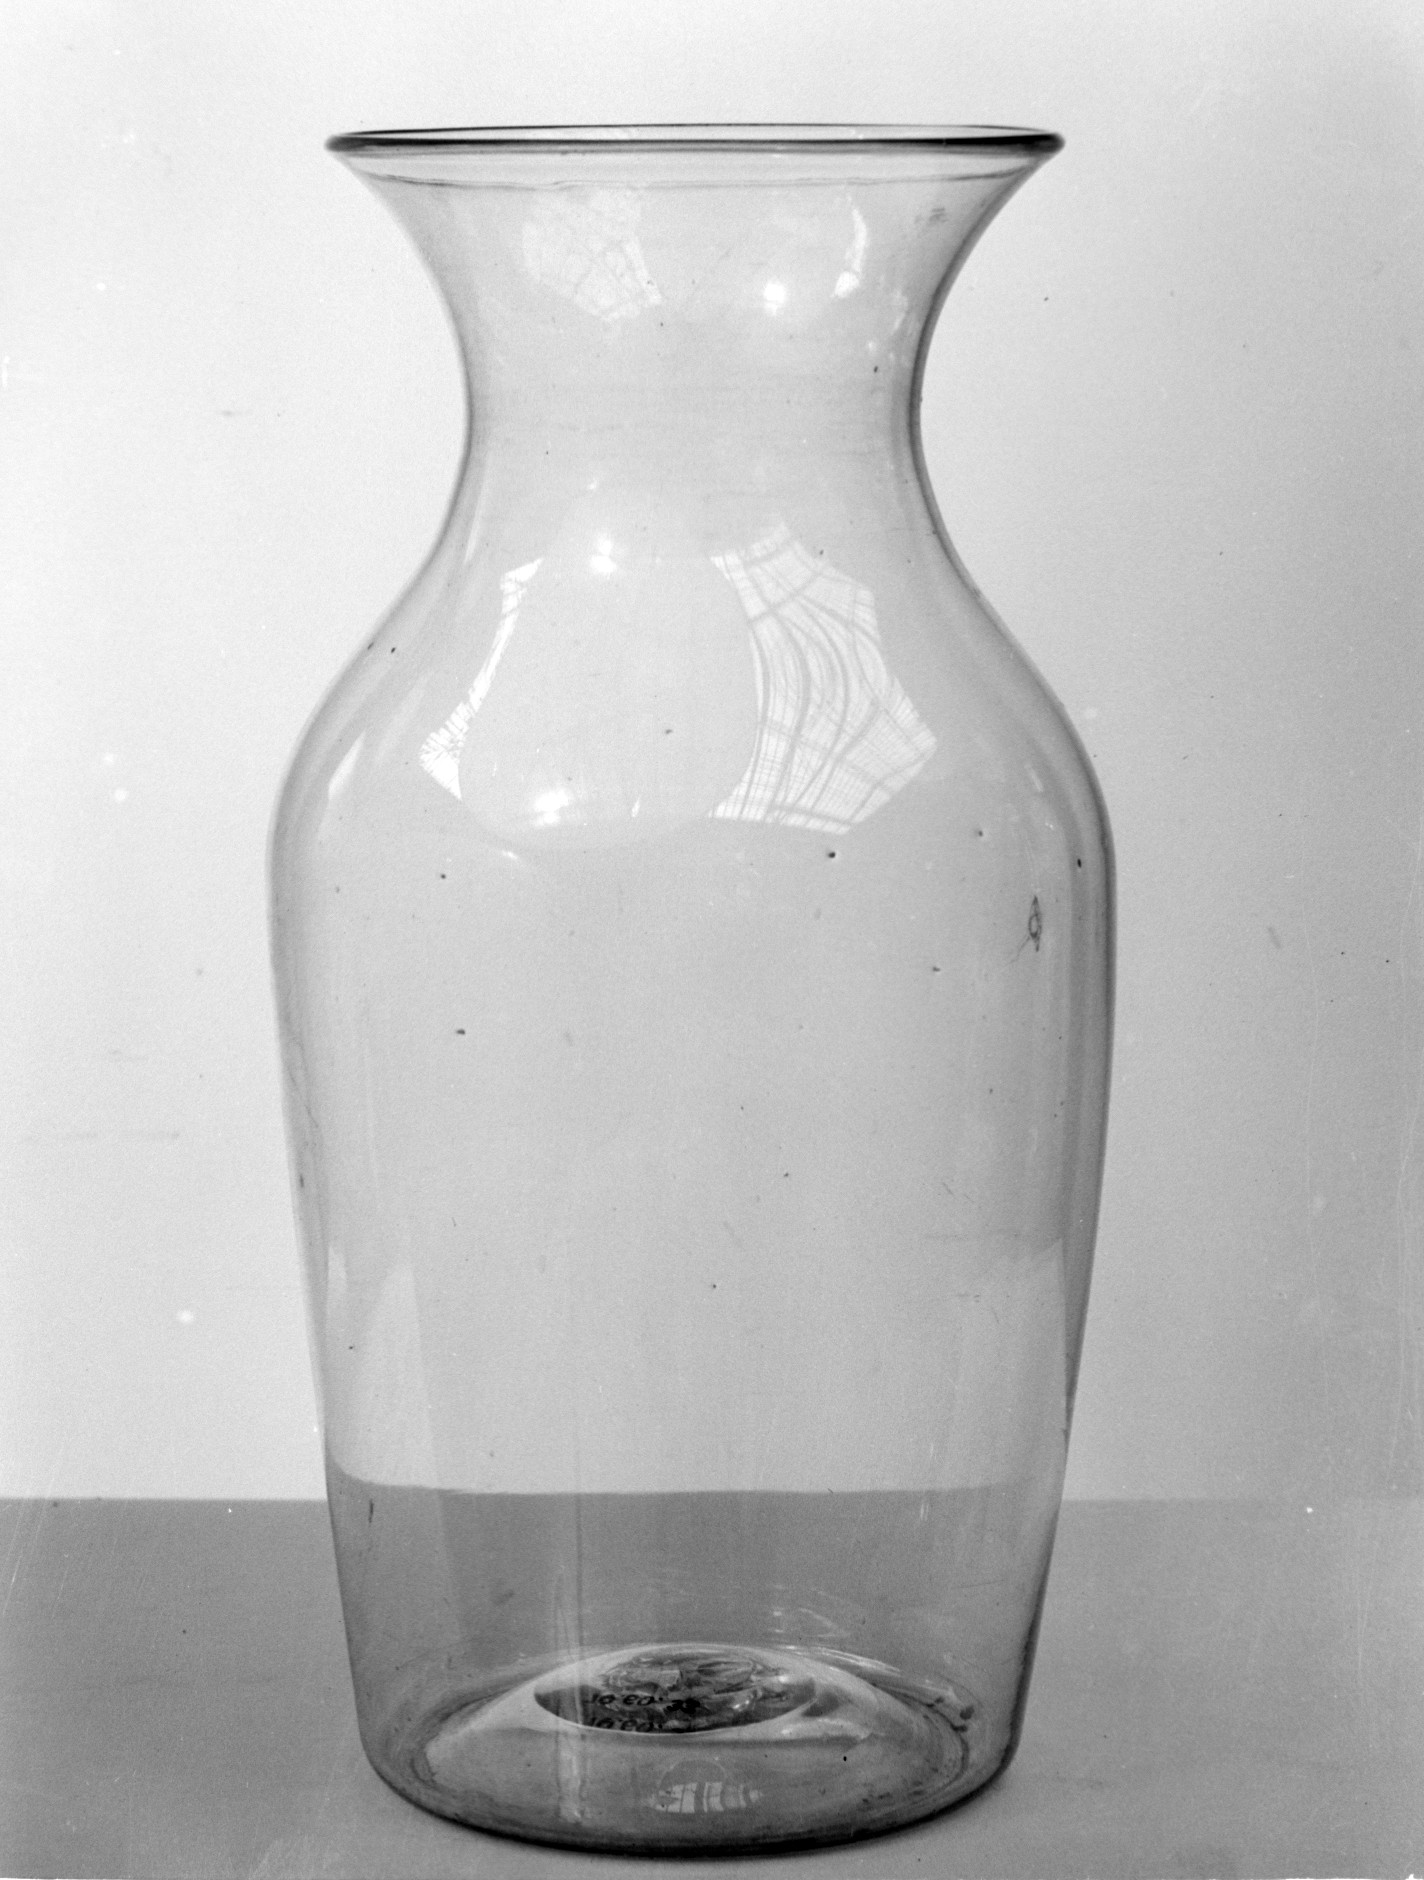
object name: vase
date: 1701-1800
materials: glass